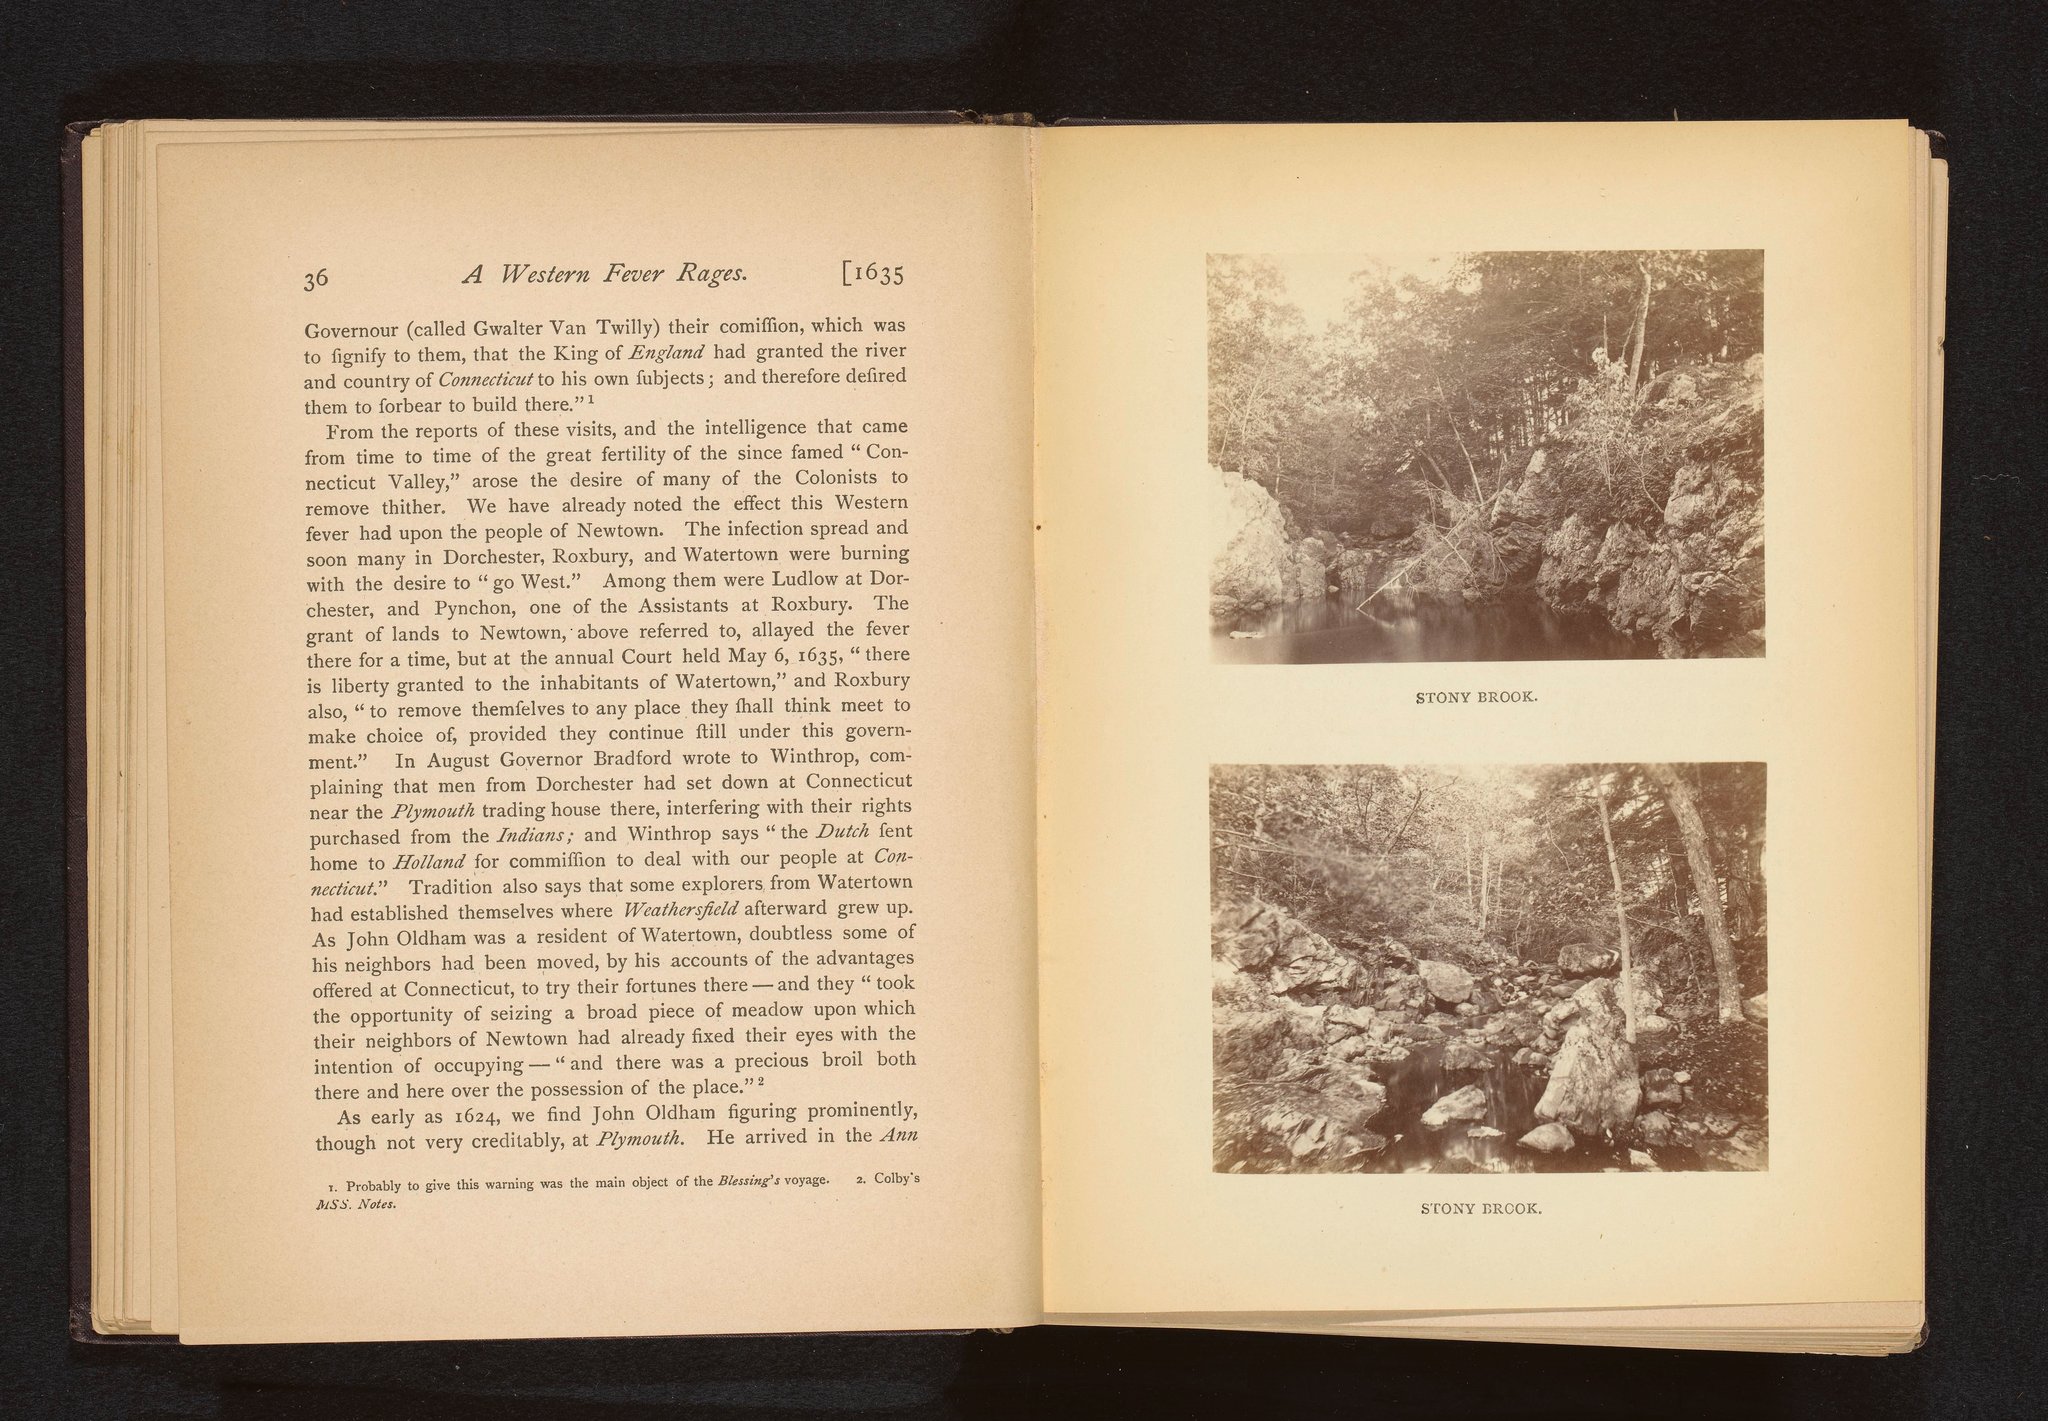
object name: photograph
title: Gezicht op Stony Brook in Norfolk, Massachusetts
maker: thomas r. lewis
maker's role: publisher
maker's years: 1845-1901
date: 1874-1879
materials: photographic support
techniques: albumen print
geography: norfolk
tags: brook, rock-formations